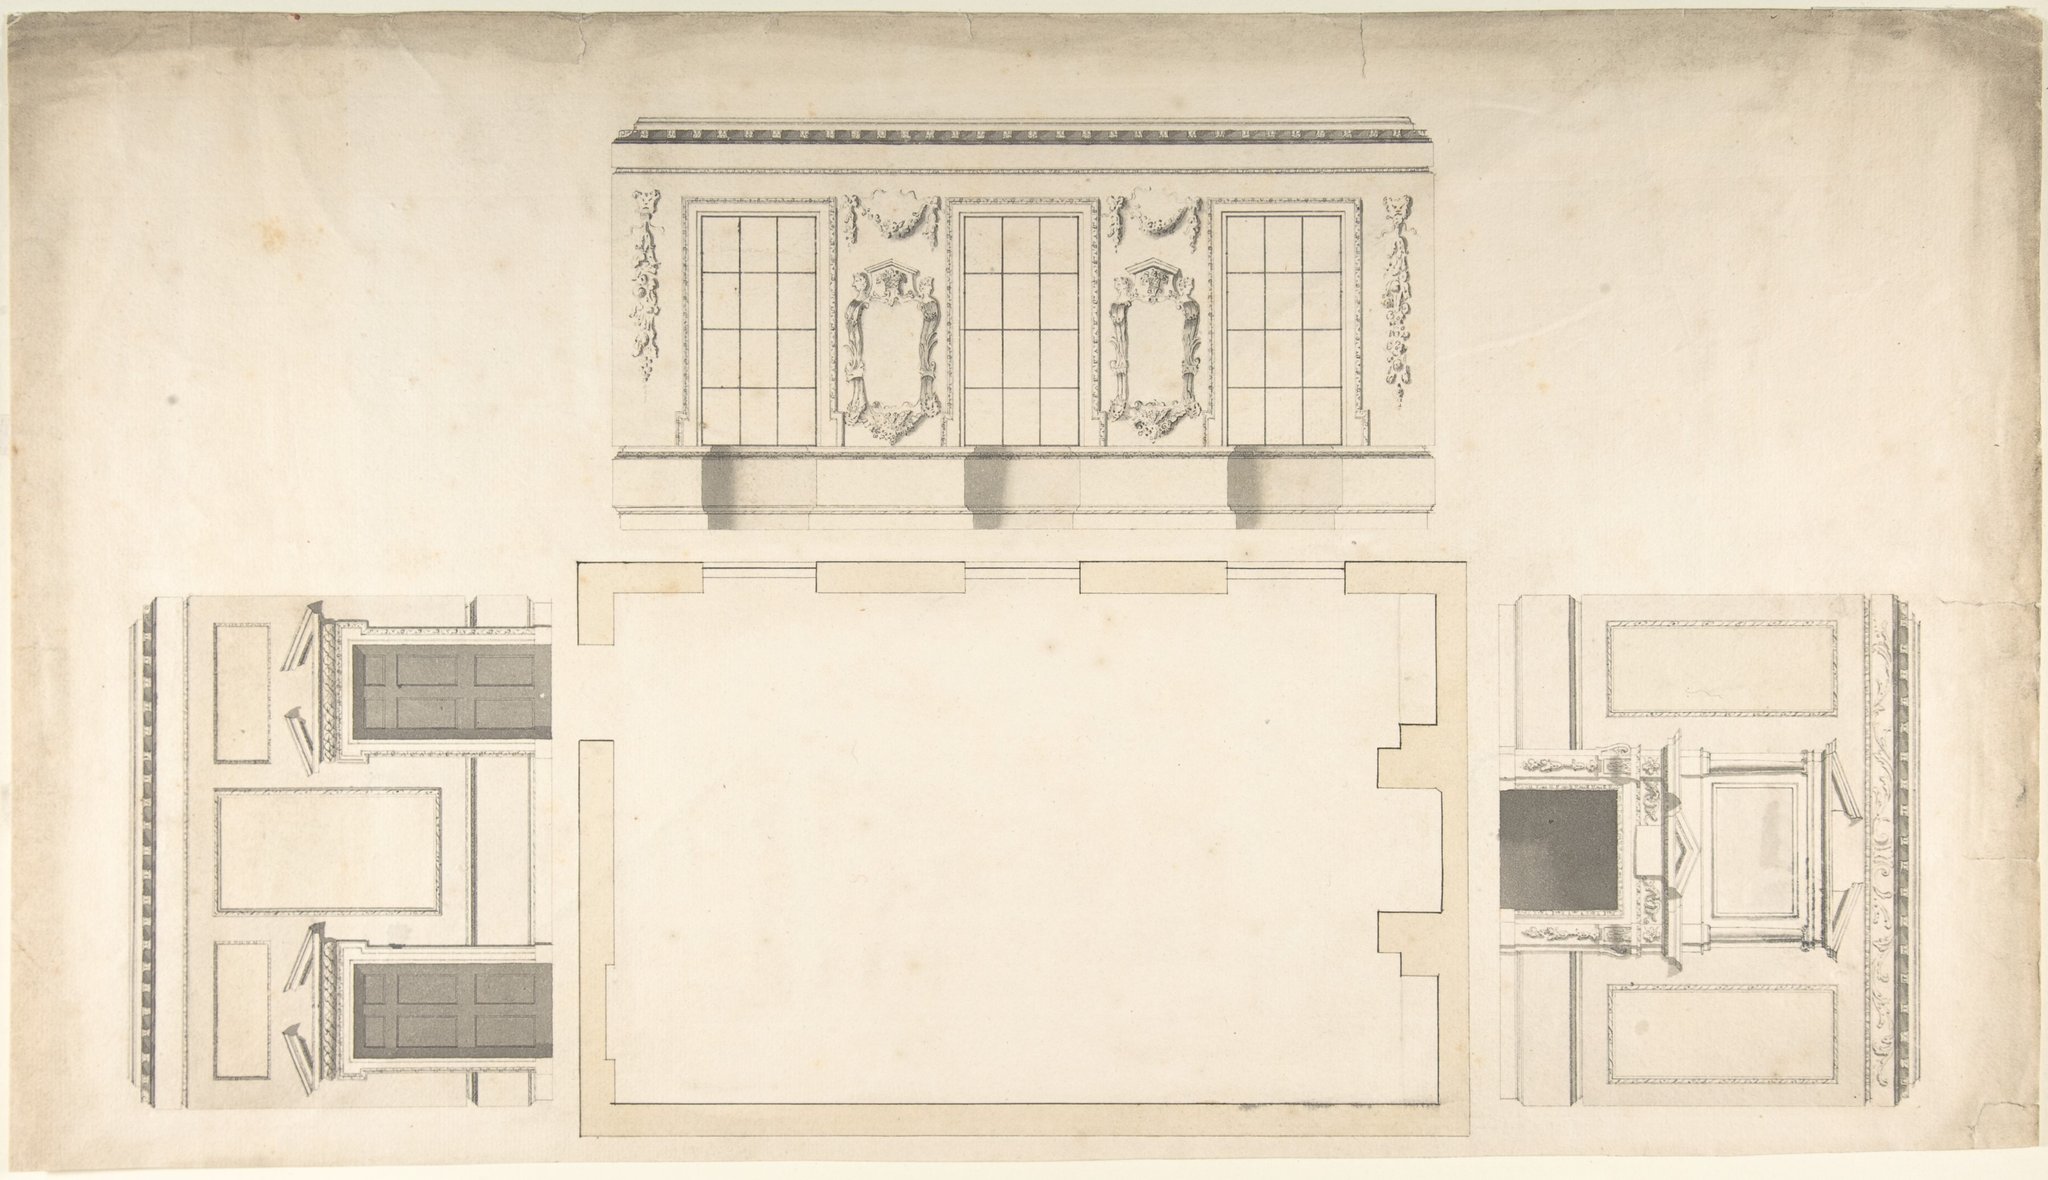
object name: drawing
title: Room Design Showing Plan and Three Wall Elevations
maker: anonymous, british, 18th century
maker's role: artist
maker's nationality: british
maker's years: 1700-1800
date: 1740-1760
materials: ink, watercolor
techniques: pen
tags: architecture